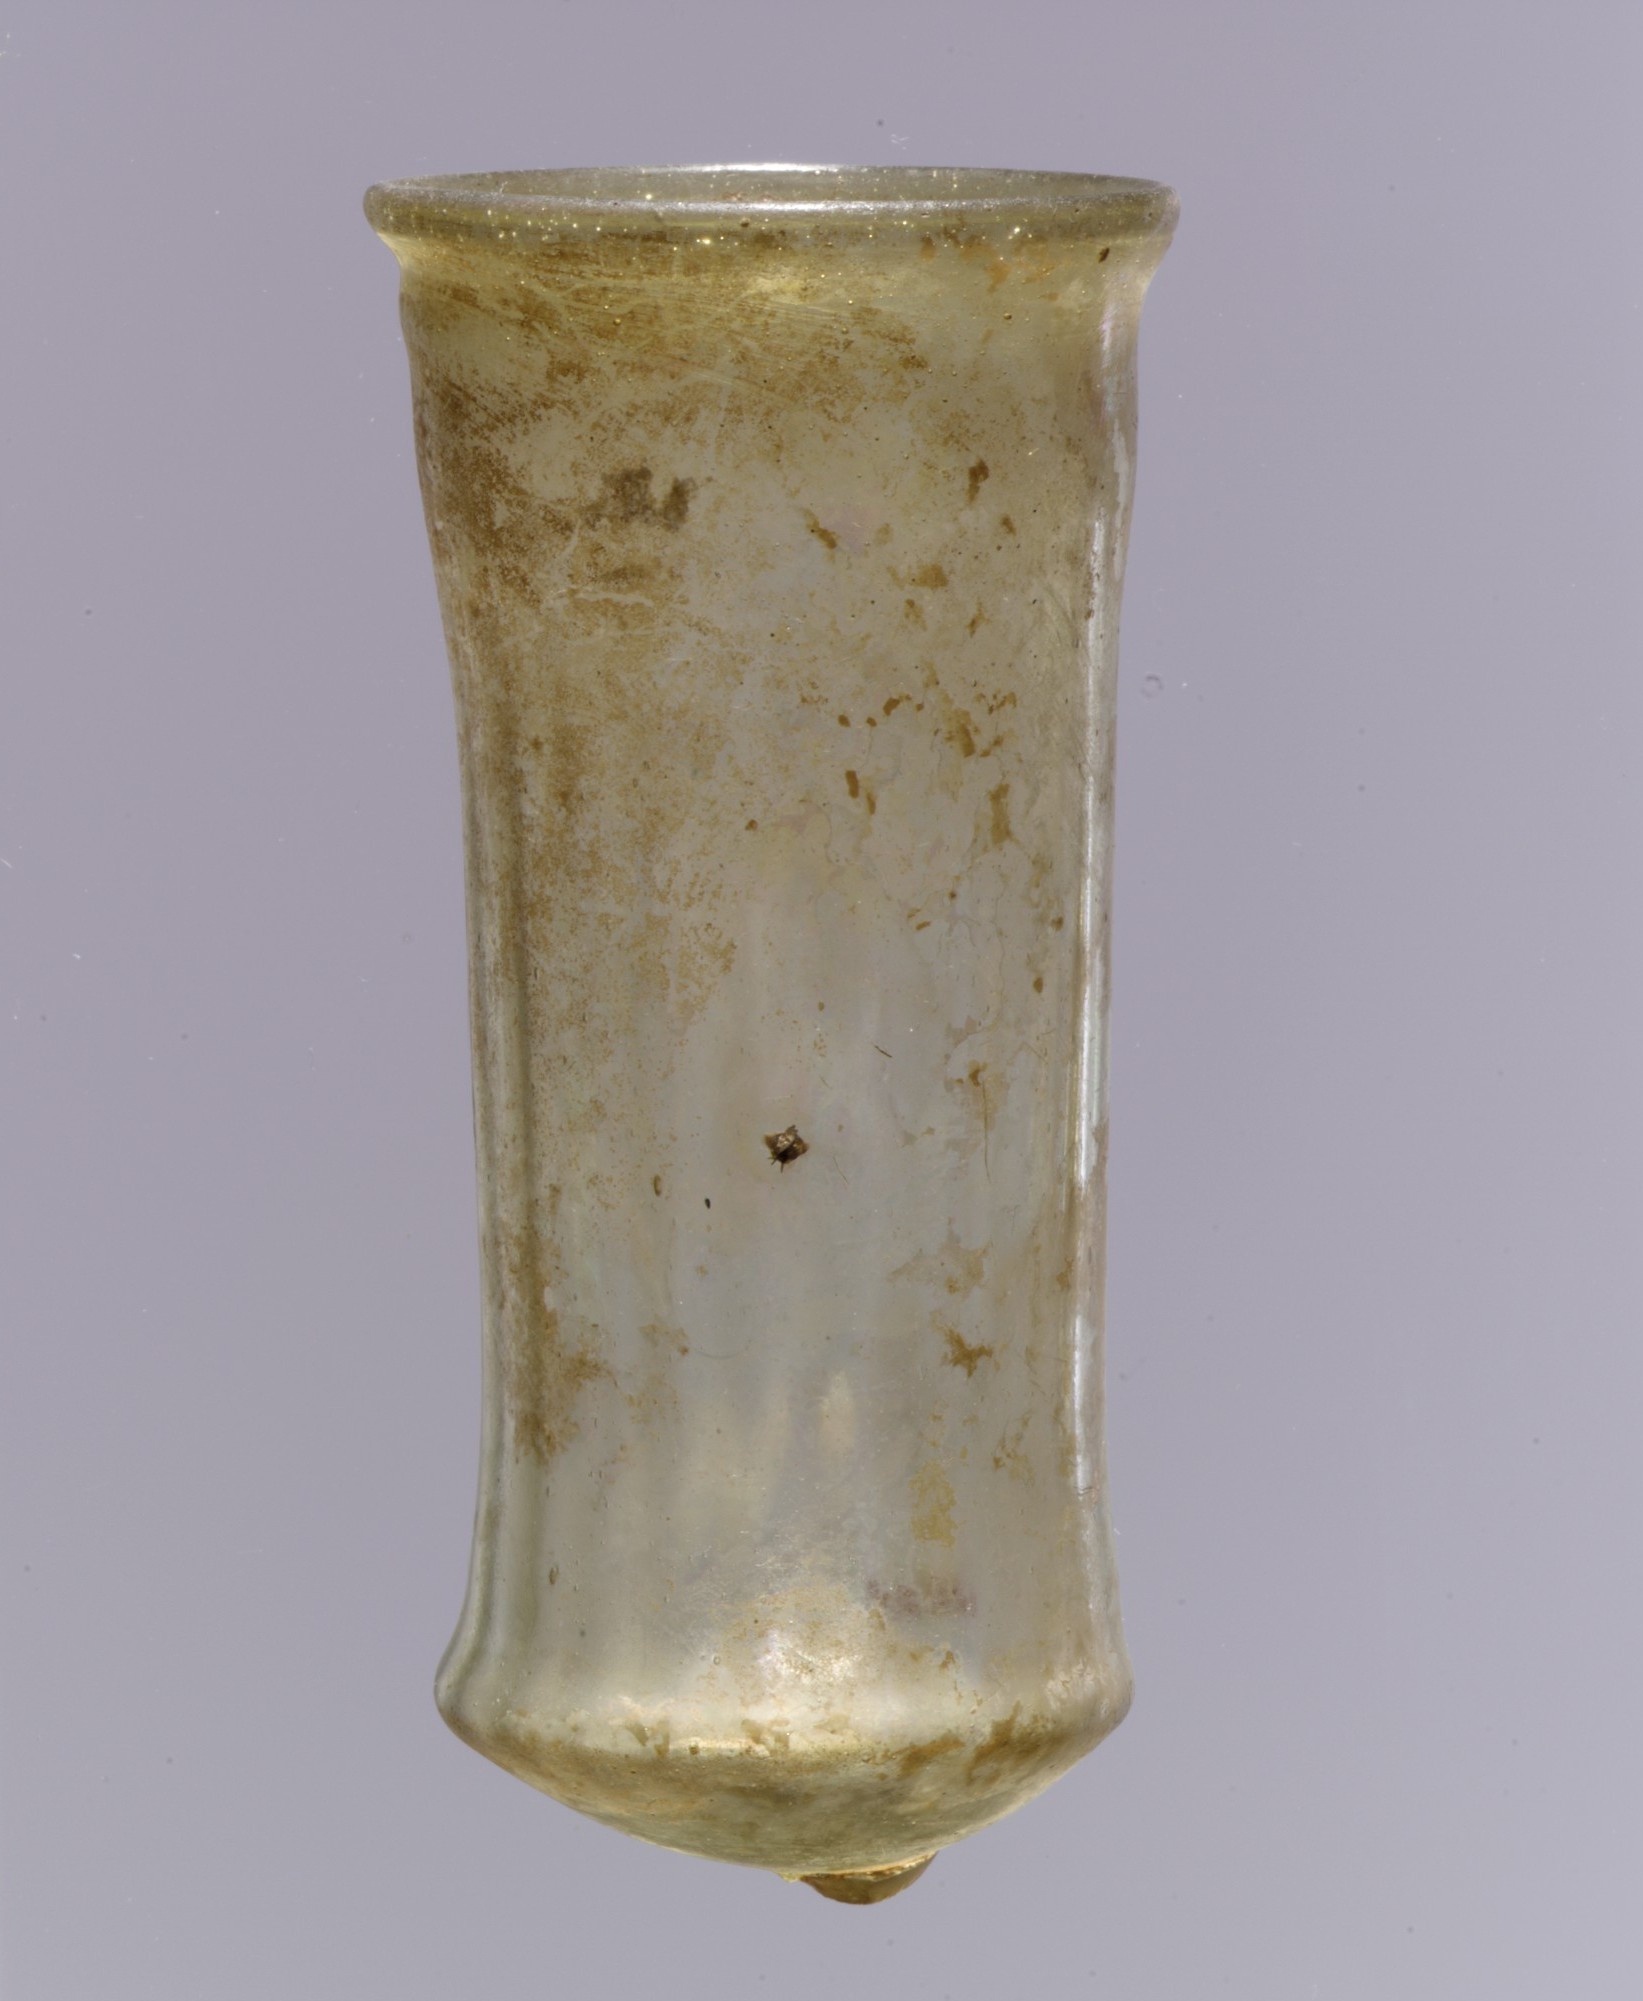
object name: beaker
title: Bell Beaker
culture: frankish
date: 567-633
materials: glass